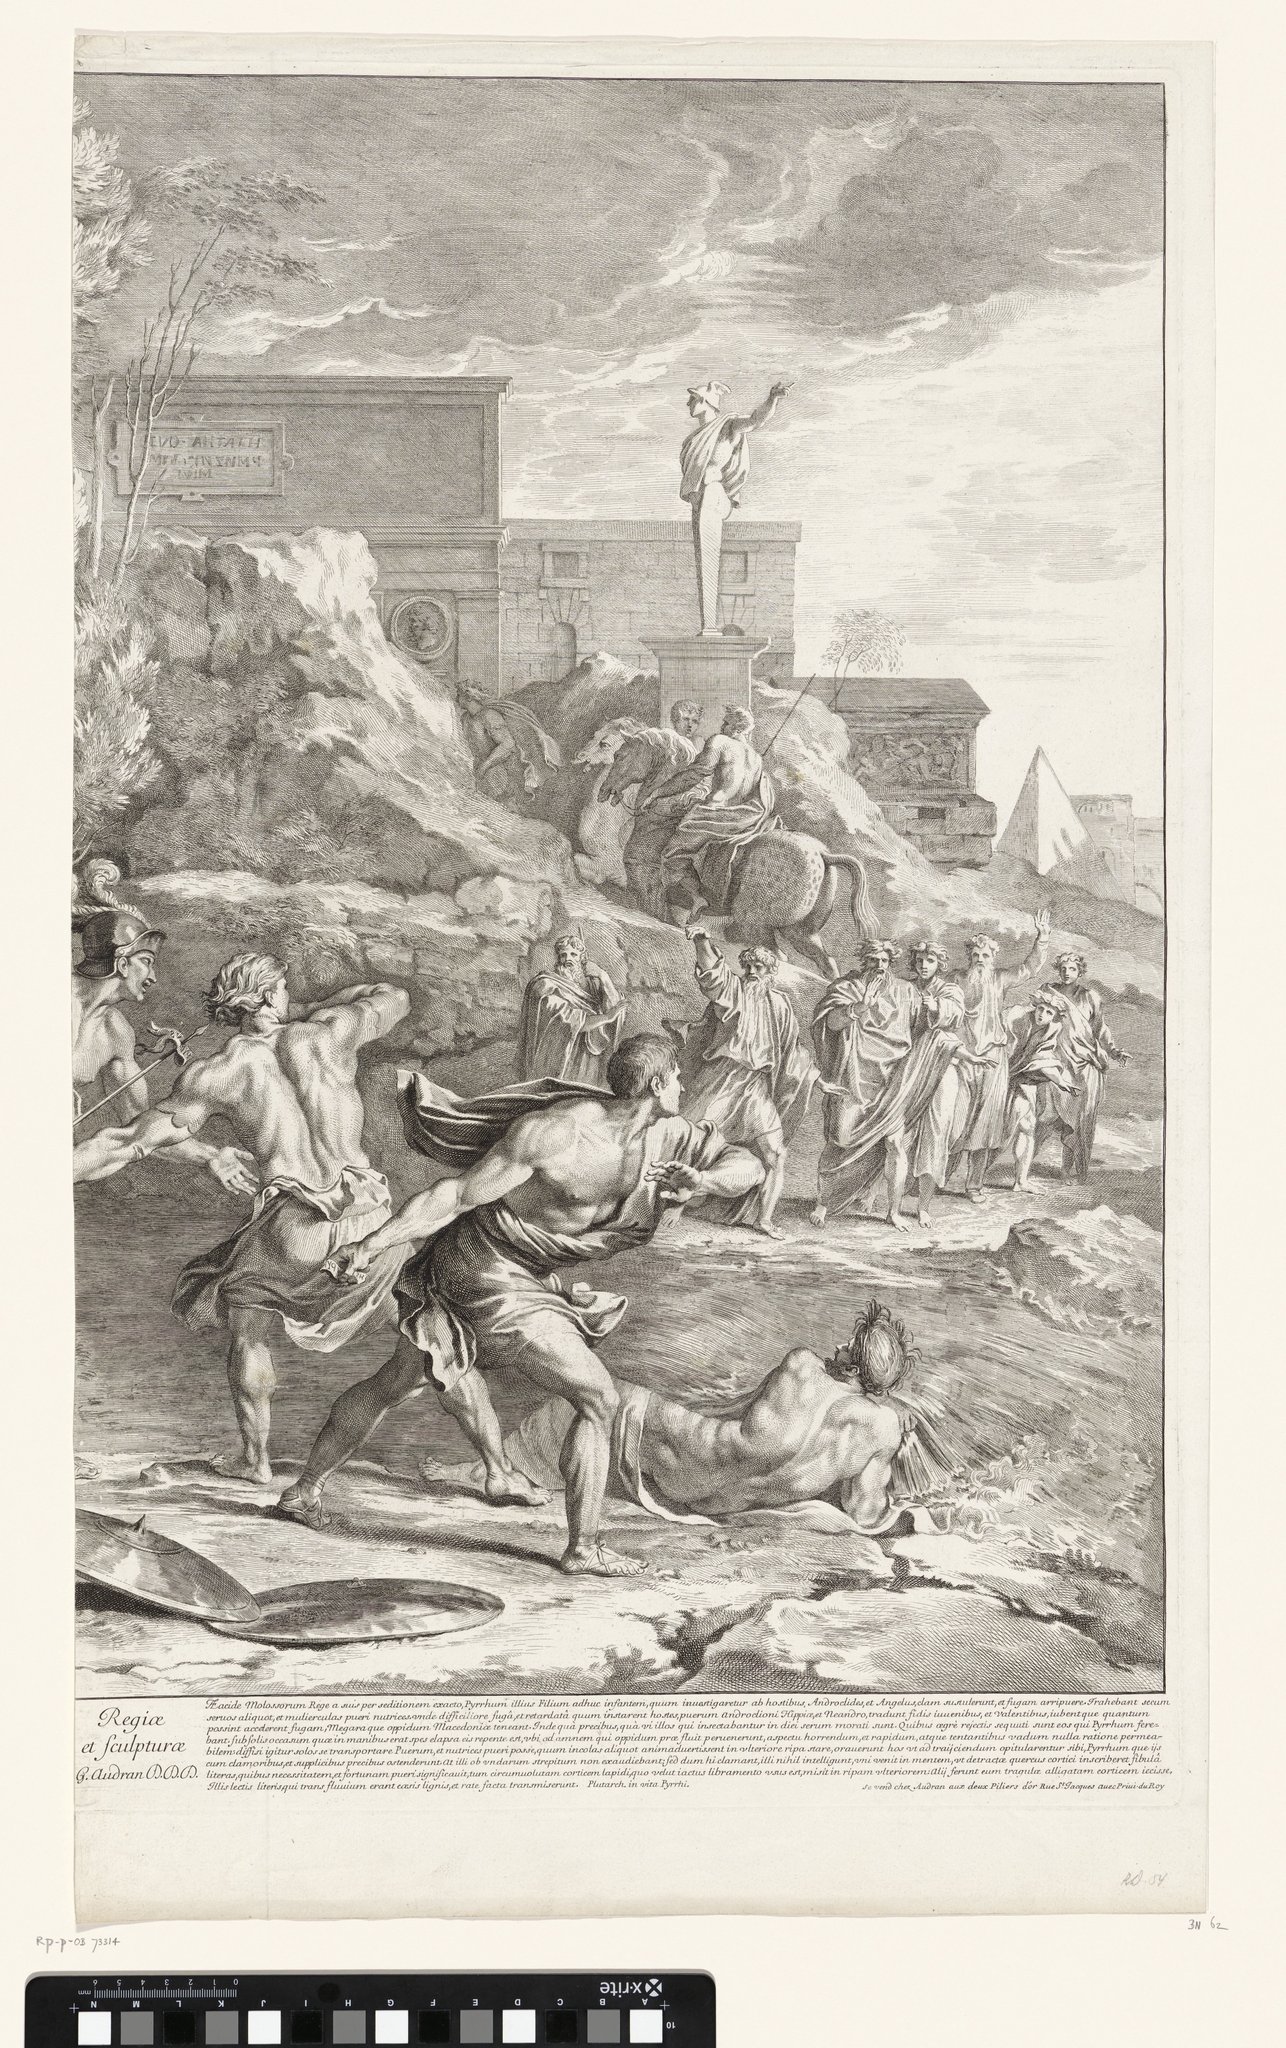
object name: print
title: De jonge Pyrrhus wordt gered (rechterblad)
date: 1650-1703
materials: paper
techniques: engraving, etching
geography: france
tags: servants save the infant pyrrhus from the pursuit of the enemies of his father; when unable to cross a swollen river unaided they hurl a message tied either to a stone or a javelin across the water beseeching help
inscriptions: collector's mark: Lugt 240, collector's mark: Lugt 1838, inscription: ‘RD.14’, inscription: ‘K.D. 14’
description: Rechterblad van een prent gedrukt van twee platen.